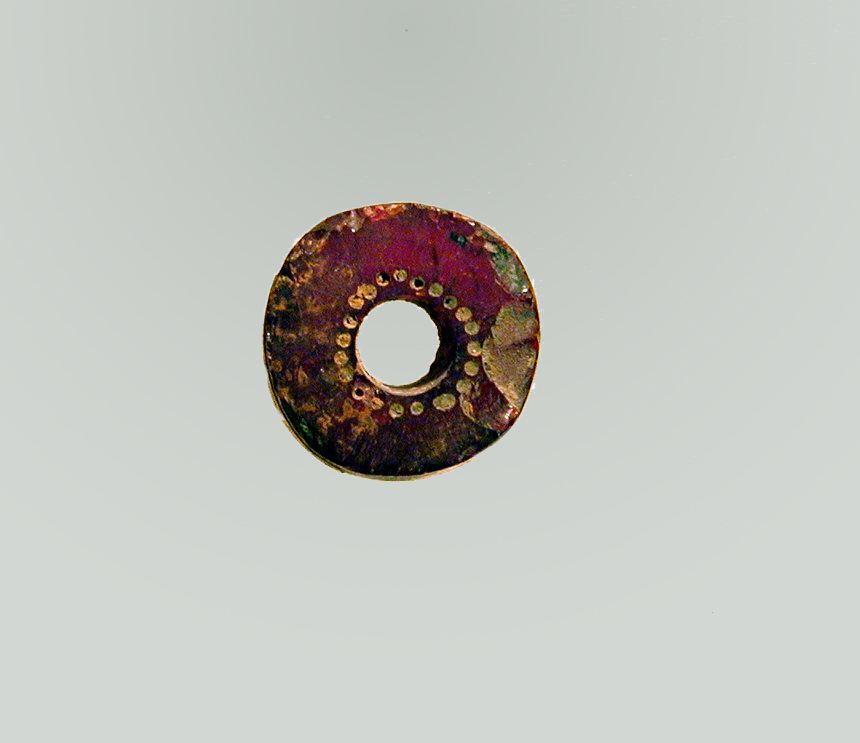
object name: fibula, fragment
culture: etruscan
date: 700-501 BCE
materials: amber